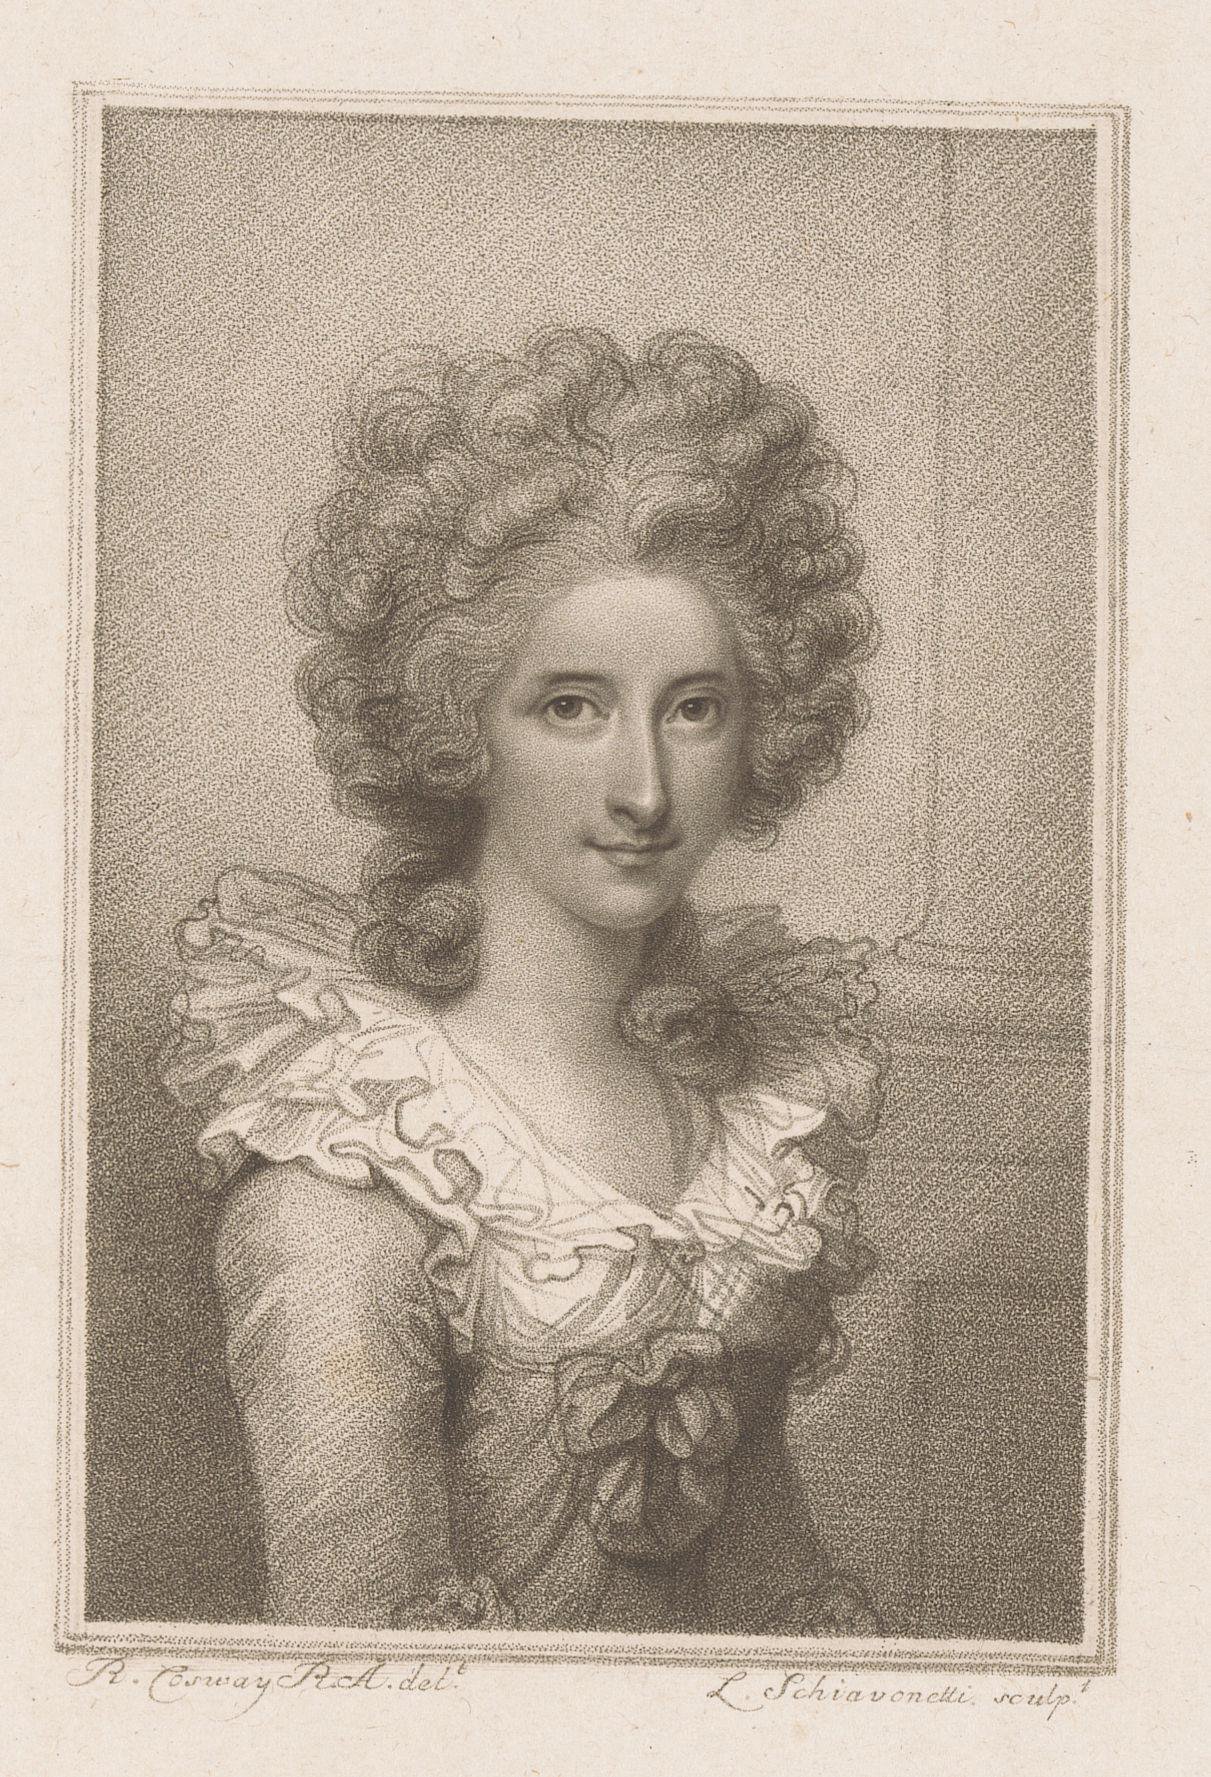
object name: print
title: Portret van beeldhouwer Anne Seymour Damer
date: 1791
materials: paper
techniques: printing, engraving, roulette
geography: london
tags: london, sculptor, anne seymour damer, historical persons, portrait, self-portrait of artist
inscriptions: collector's mark: Lugt 2233